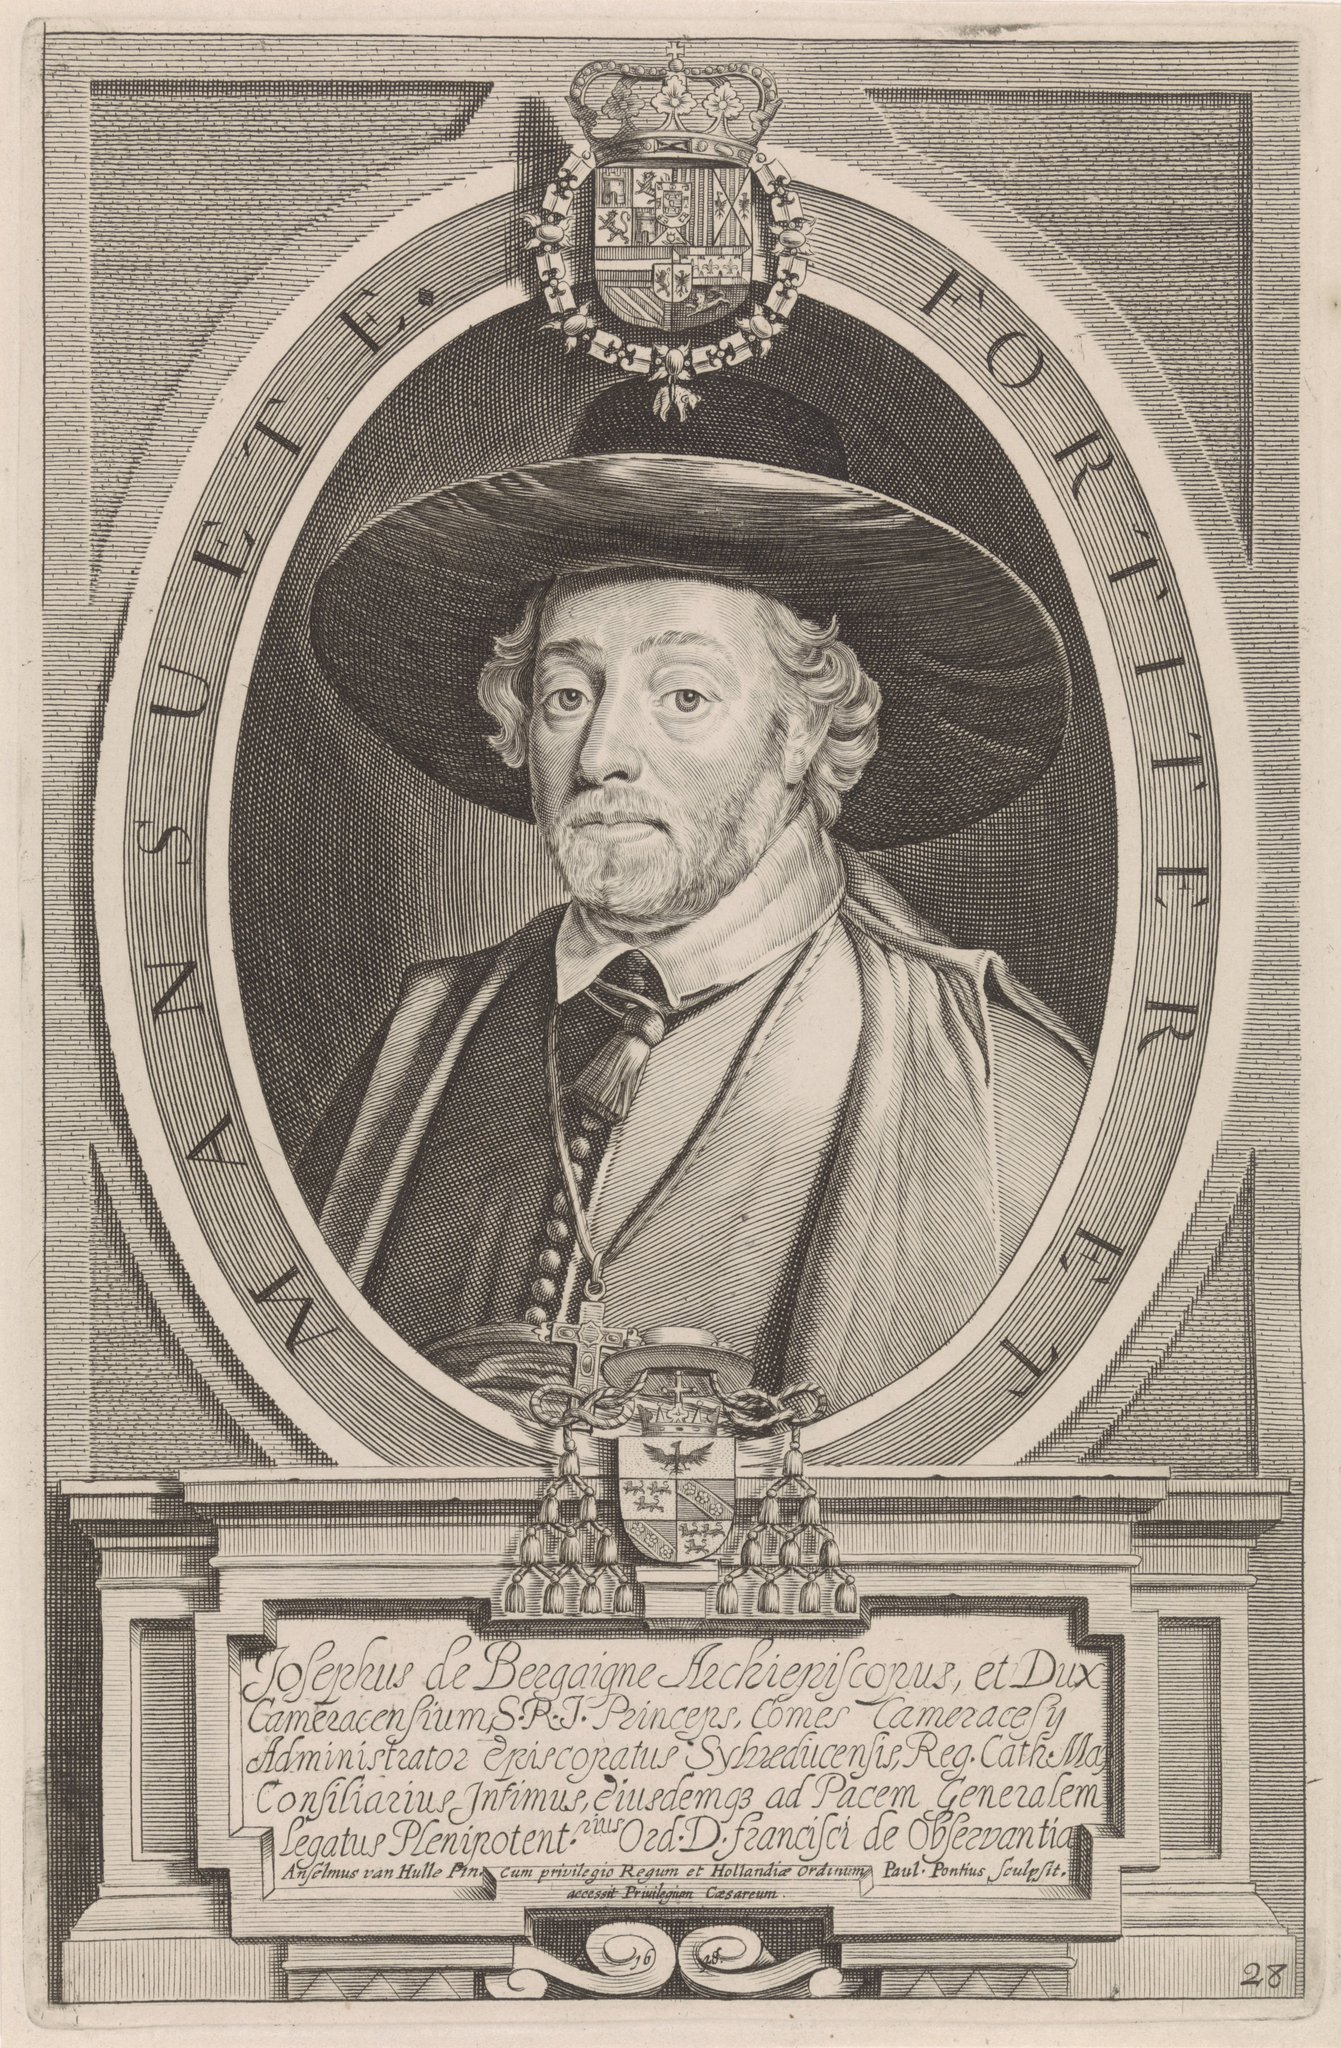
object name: print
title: Portret van de bisschop Joseph de Bergaigne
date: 1648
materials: paper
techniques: engraving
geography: antwerp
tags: archbishop, bishop, etc. (roman catholic), armorial bearing, heraldry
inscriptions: collector's mark: Lugt 2228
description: Prent ook opgenomen in: Pacificatores orbis christiani, sive Icones principum, ducum et legatorum, qui Monasterii atque Osnabrugæ pacem Europæ reconciliarunt (...). = Pronkbeelden der vorsten, en vredehandelaars. Rotterdam: Pieter van der Slaart, 1697.